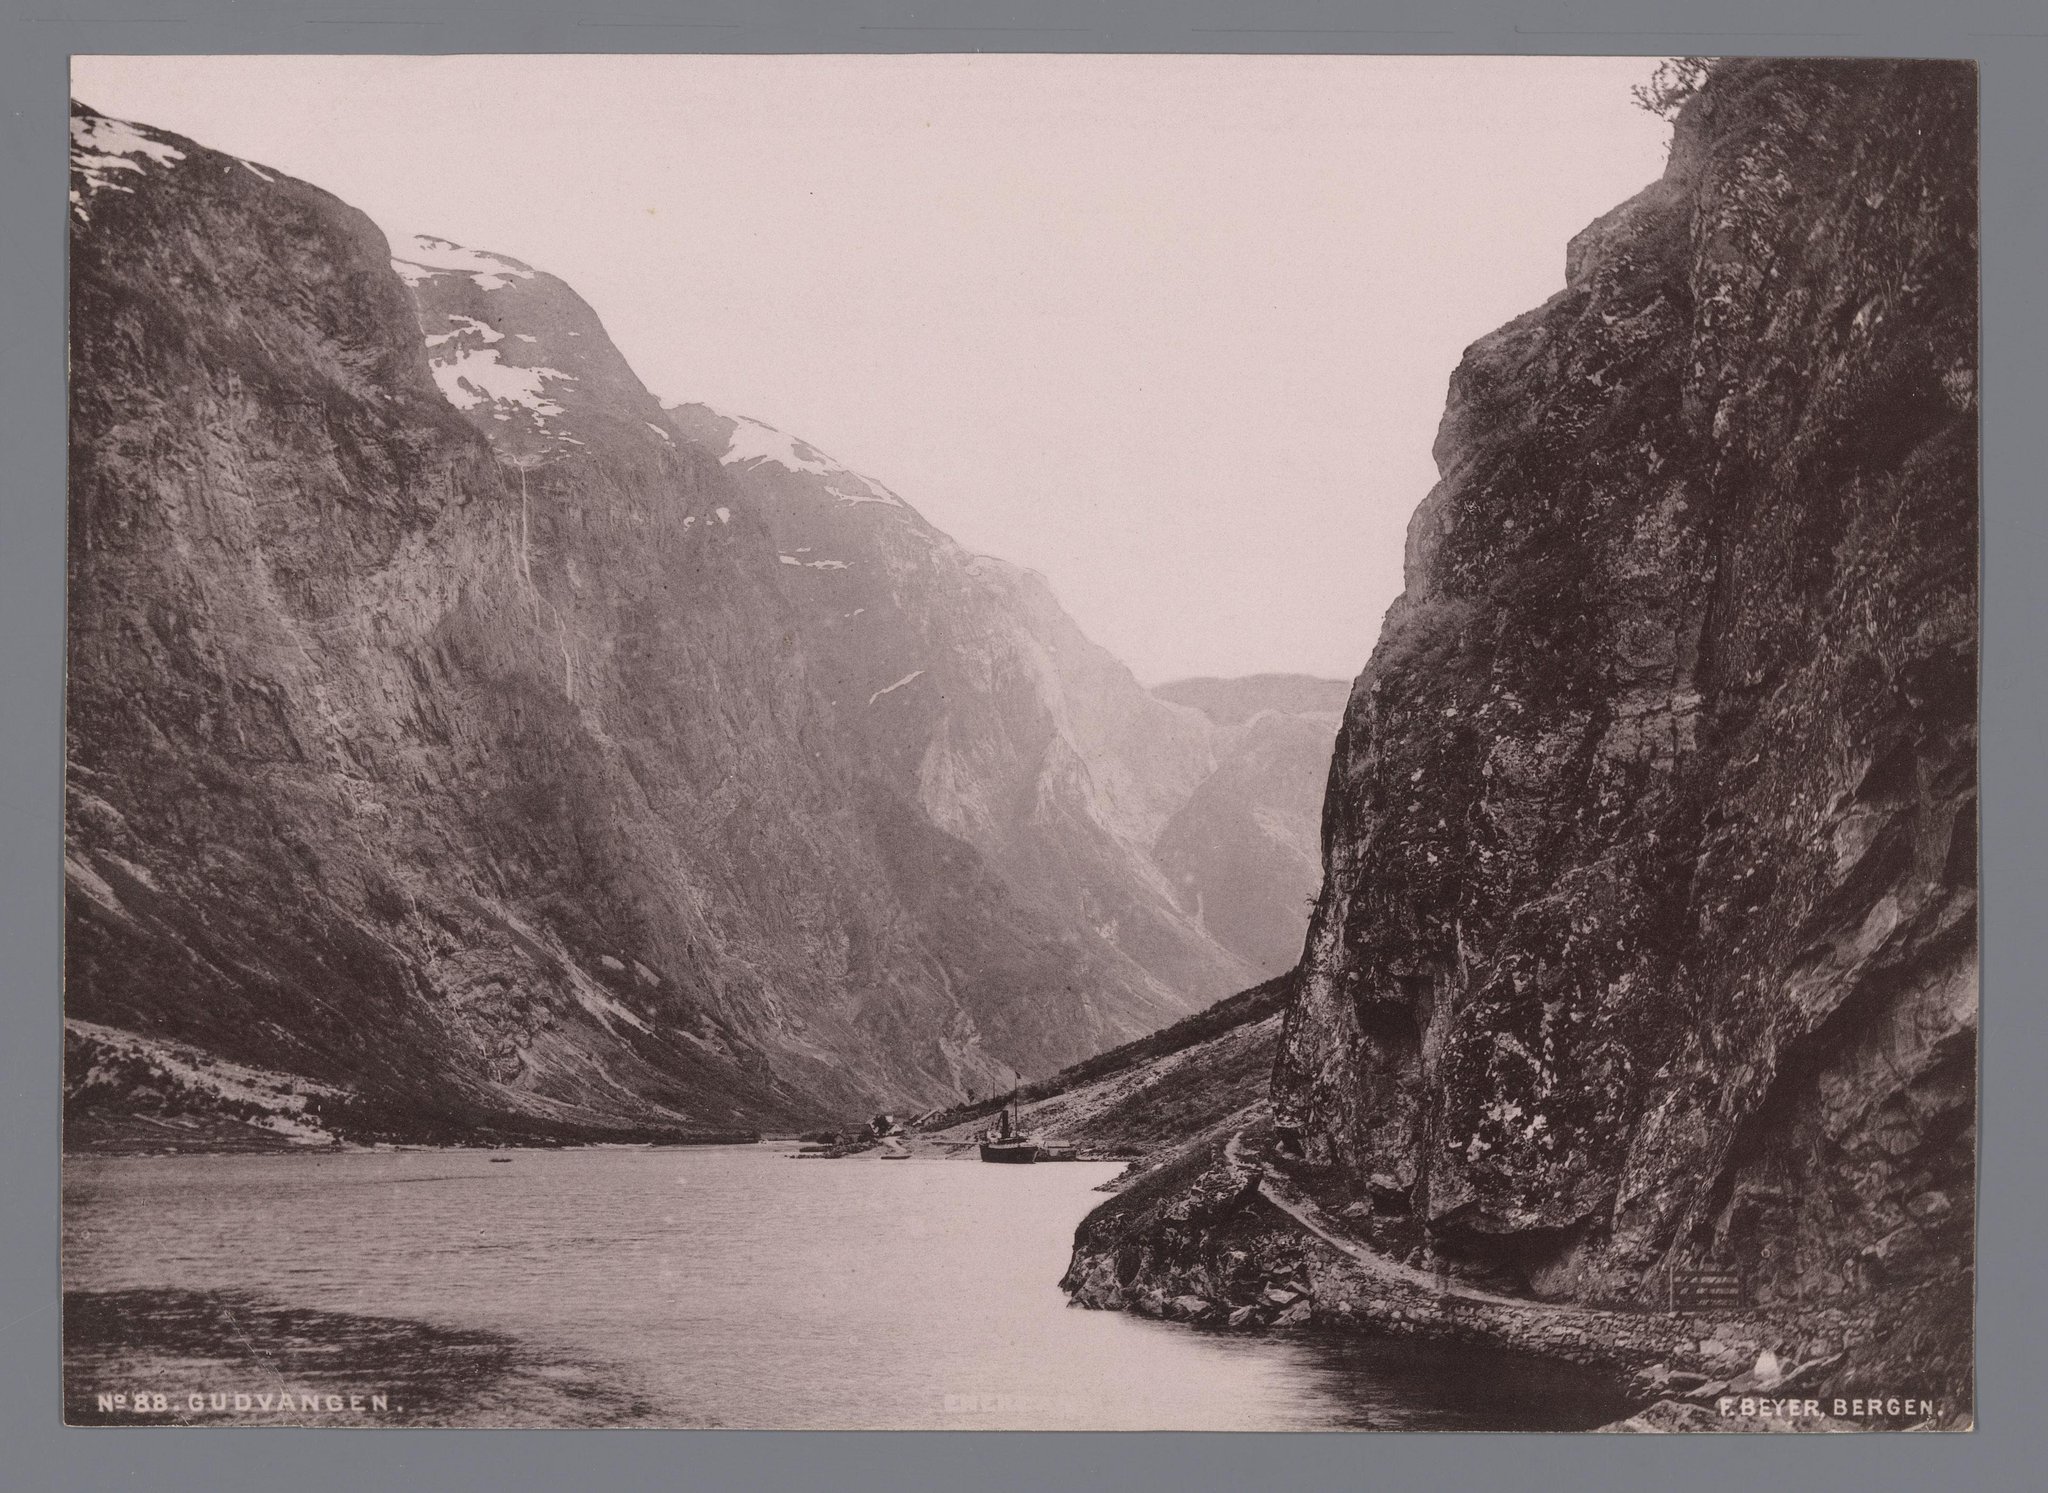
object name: photomechanical print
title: Gudvangen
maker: Anonymous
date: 1870-1919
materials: paper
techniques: photograph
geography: bergen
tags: fjord, sea loch - hh - ideal landscapes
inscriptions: name: ‘No 88.’